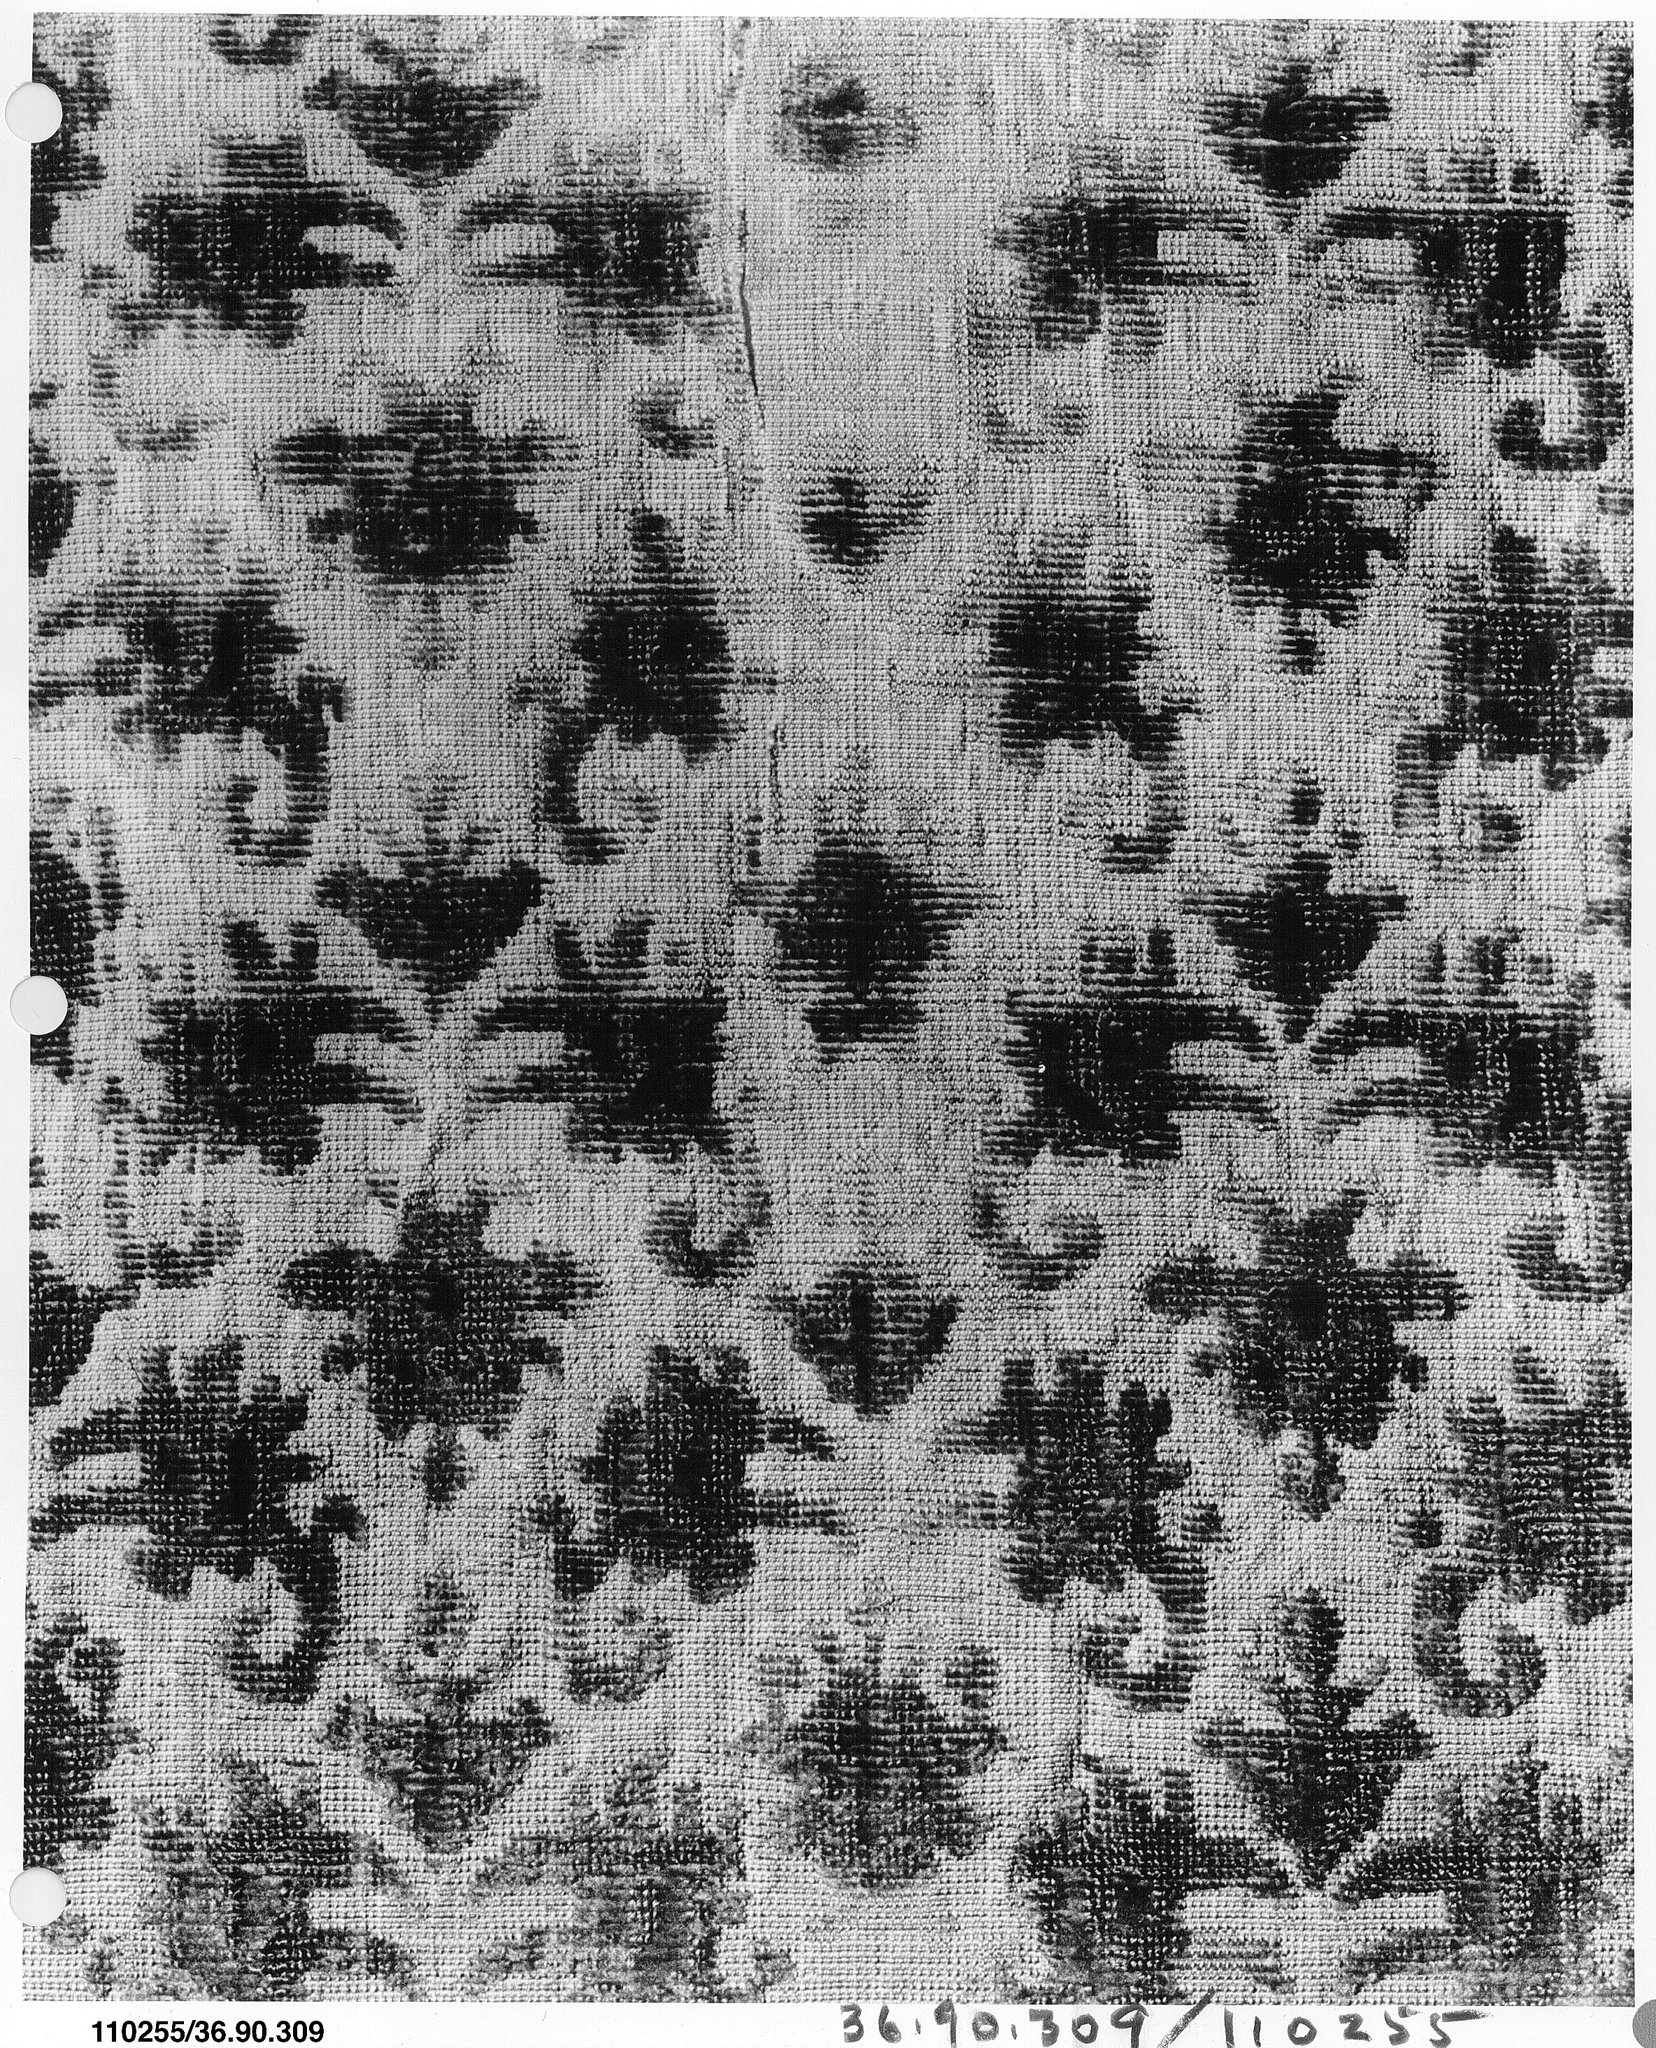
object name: piece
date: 1501-1700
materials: metal thread, silk